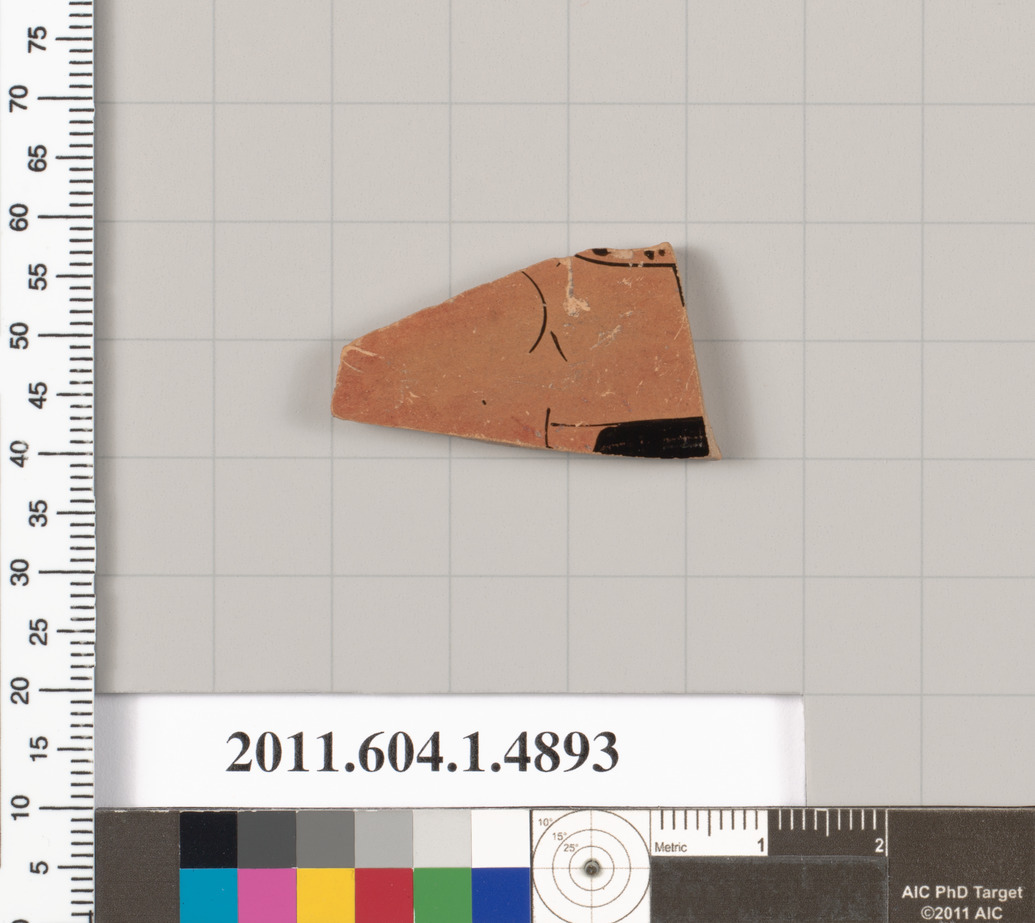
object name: kylix fragment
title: Terracotta fragment of a kylix (drinking cup)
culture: greek, attic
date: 475-451 BCE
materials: terracotta